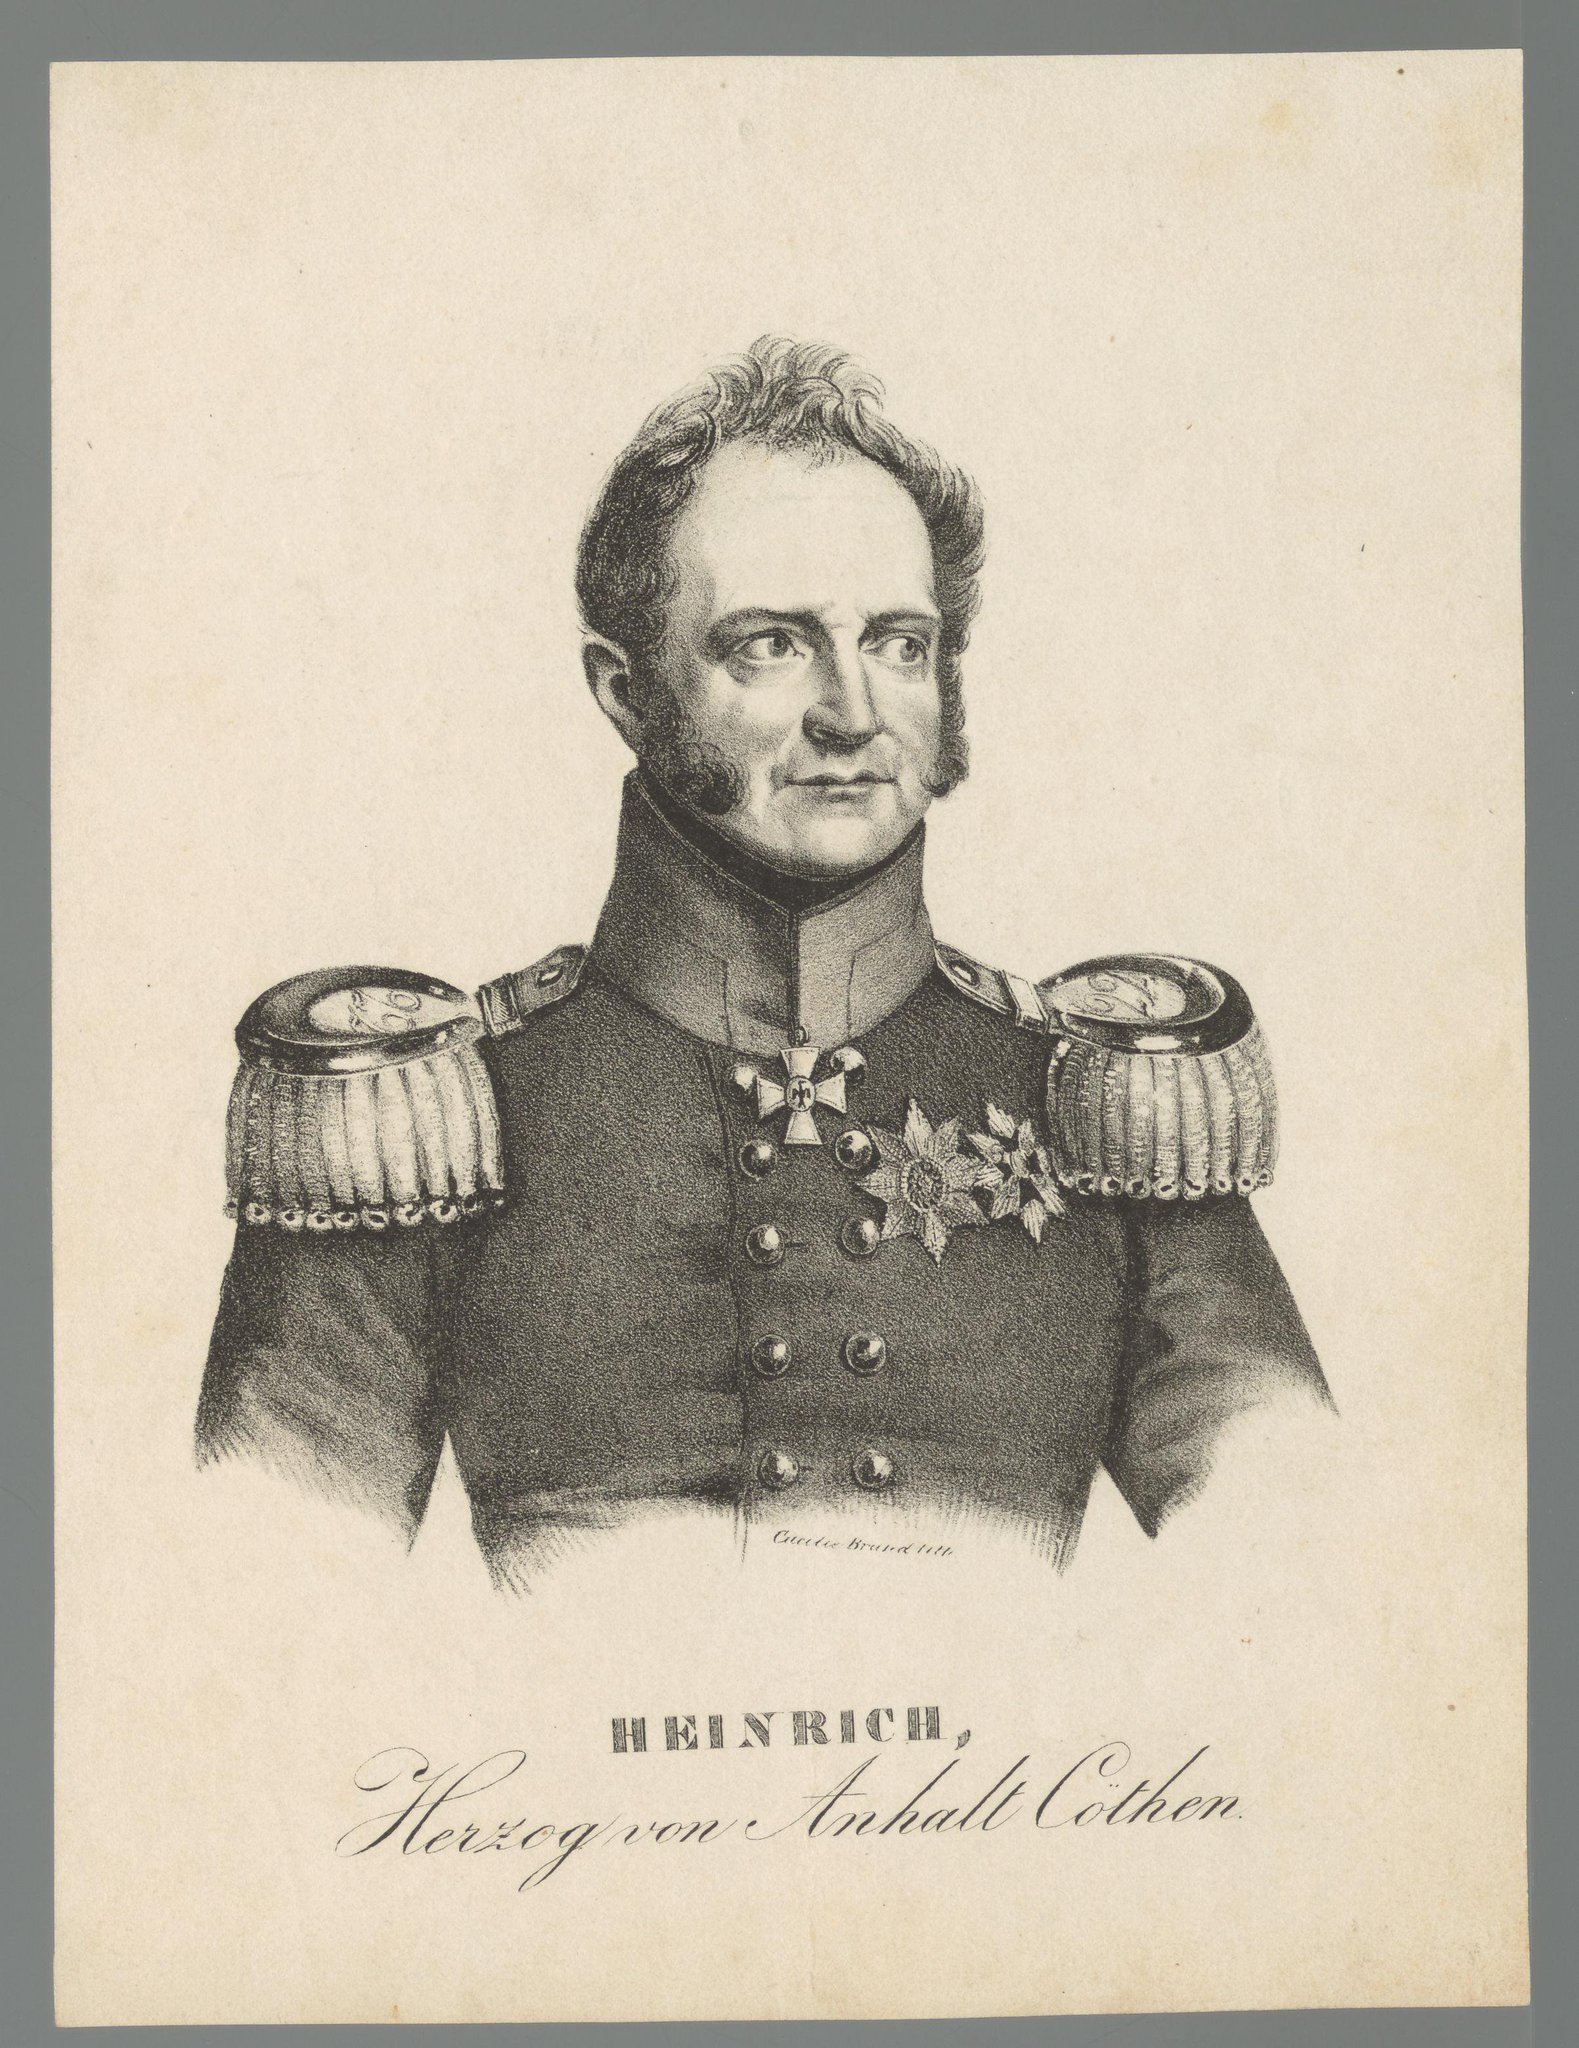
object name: print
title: Portret van Hendrik van Anhalt-Köthen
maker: cäcilie brandt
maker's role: print maker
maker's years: 1814-1852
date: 1825-1850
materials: paper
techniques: lithograph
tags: adult man, historical persons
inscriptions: collector's mark: Lugt 2228